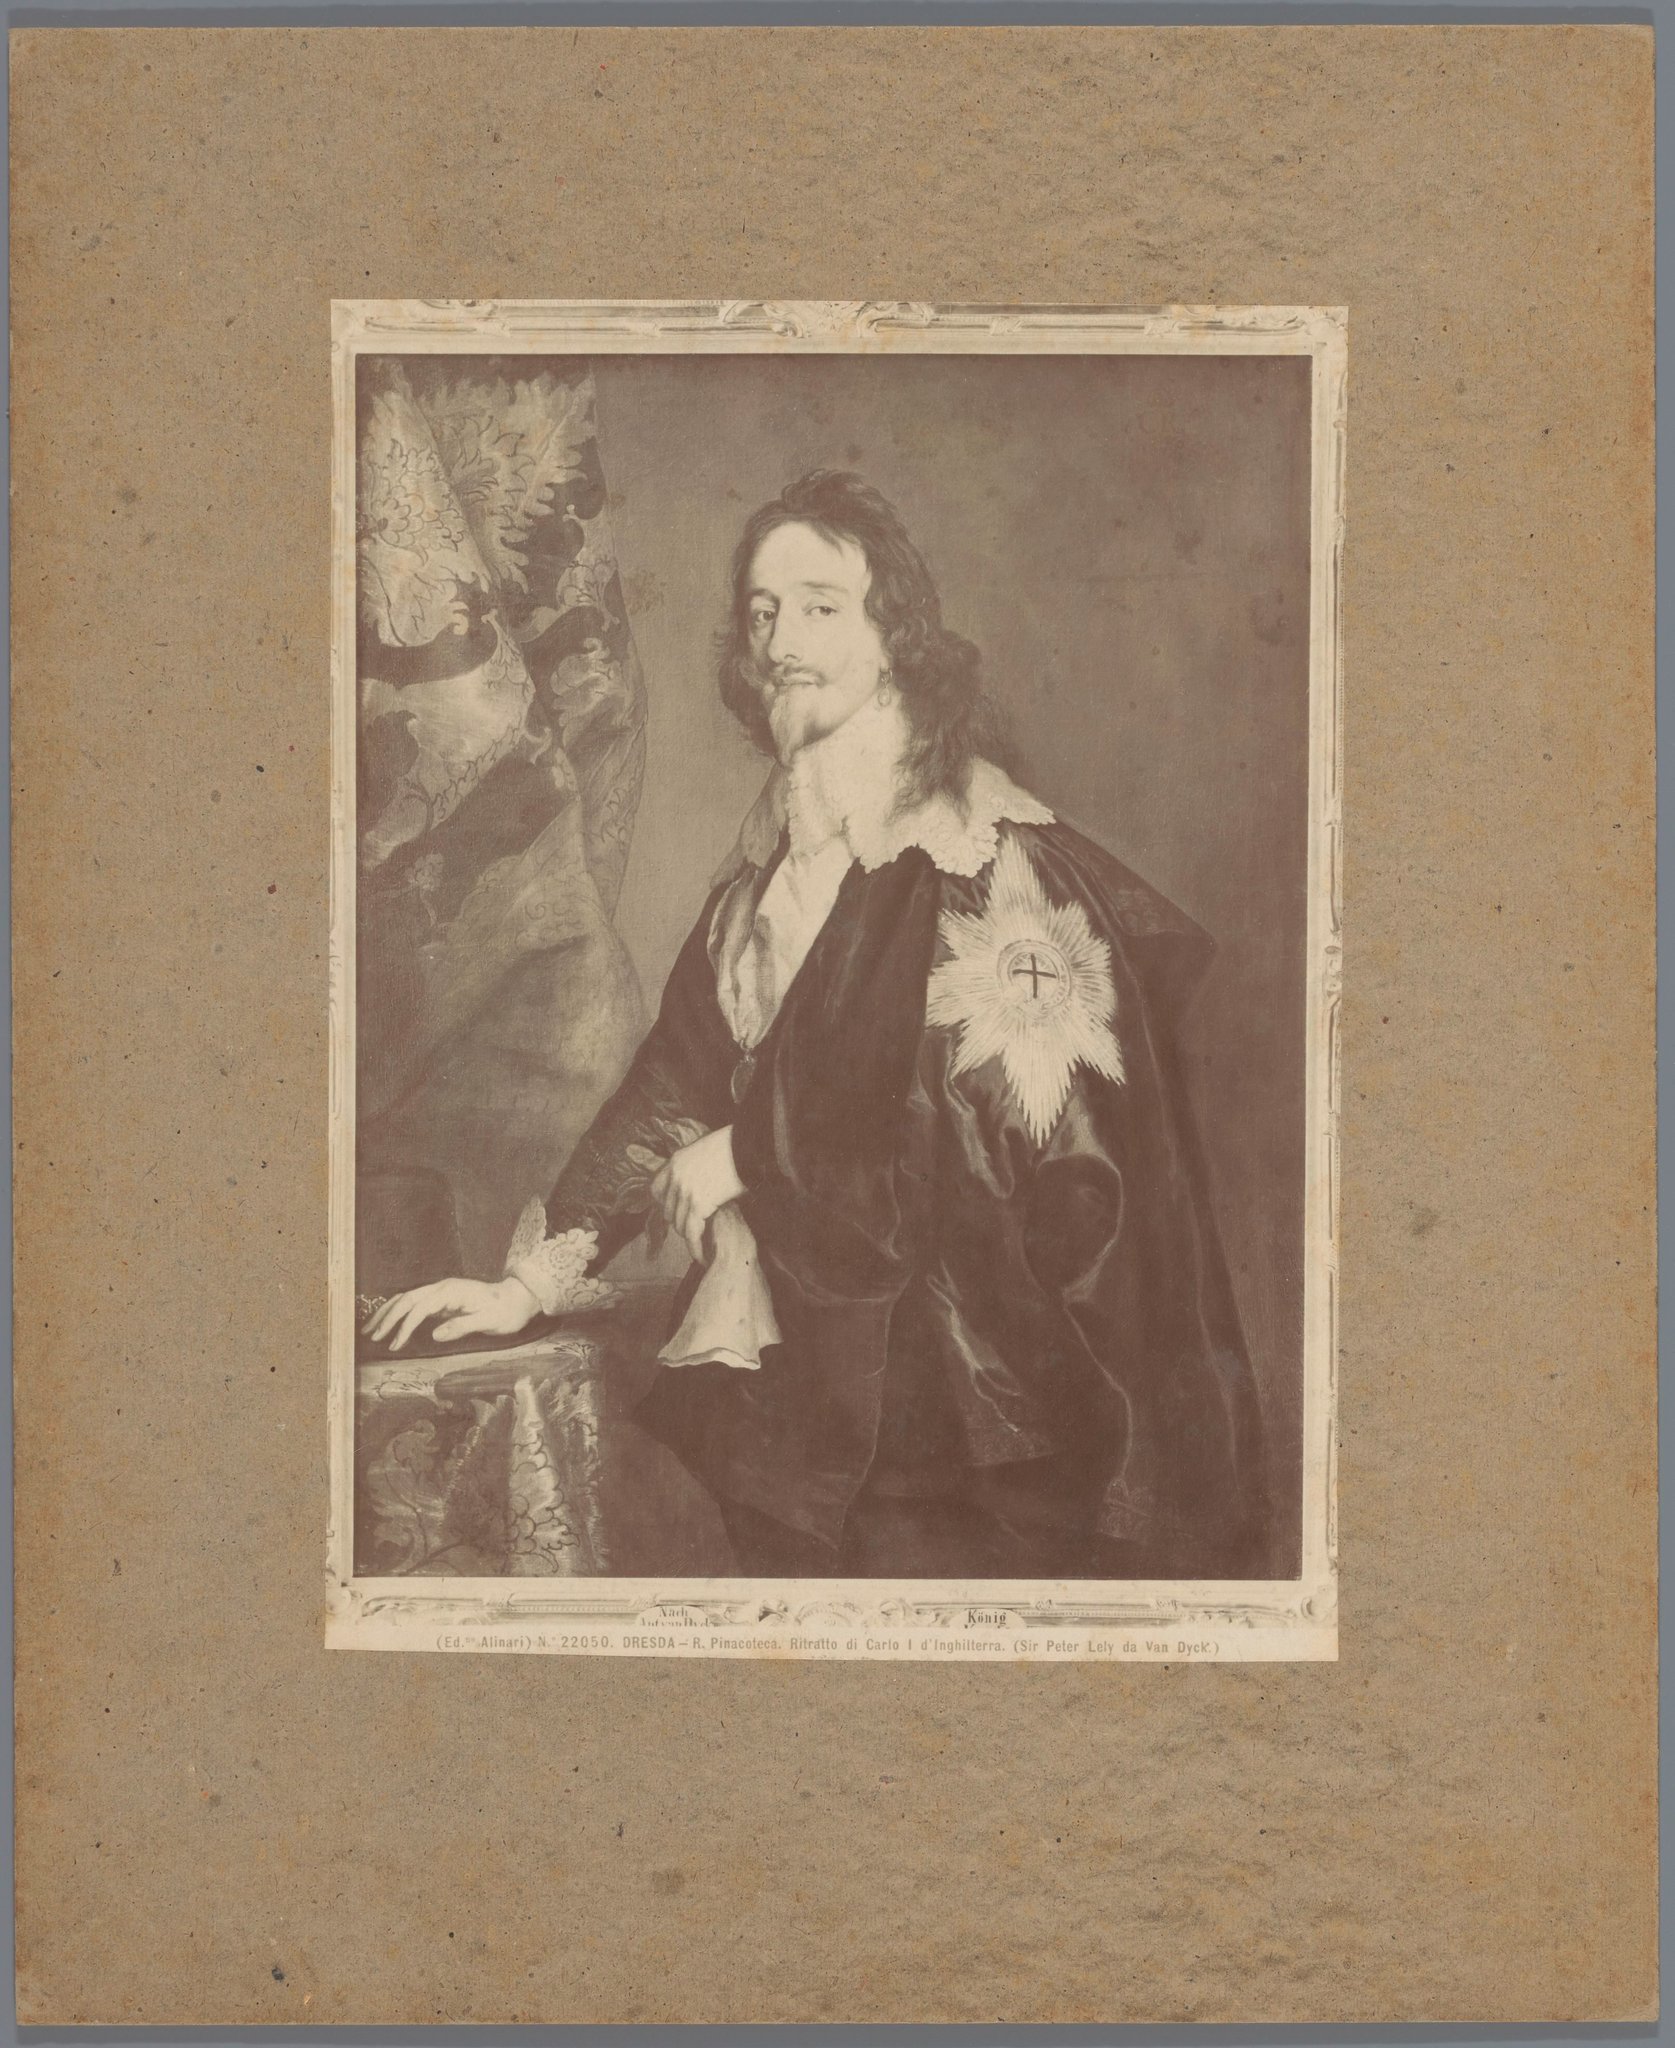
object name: reproduction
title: Fotoreproductie van een schilderij door Anthony van Dyck, voorstellende een portret van koning Karel I van Engeland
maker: anthony van dyck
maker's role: draughtsman, painter, print maker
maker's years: 1599-1641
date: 1875-1900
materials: cardboard, photographic support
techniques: albumen print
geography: europe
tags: gloves, mittens, etc., historical persons (portraits and scenes from the life), flag, colours (as symbol of the state, etc.), europe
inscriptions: collector's mark: Lugt 3937, number: ‘No. 22050.’